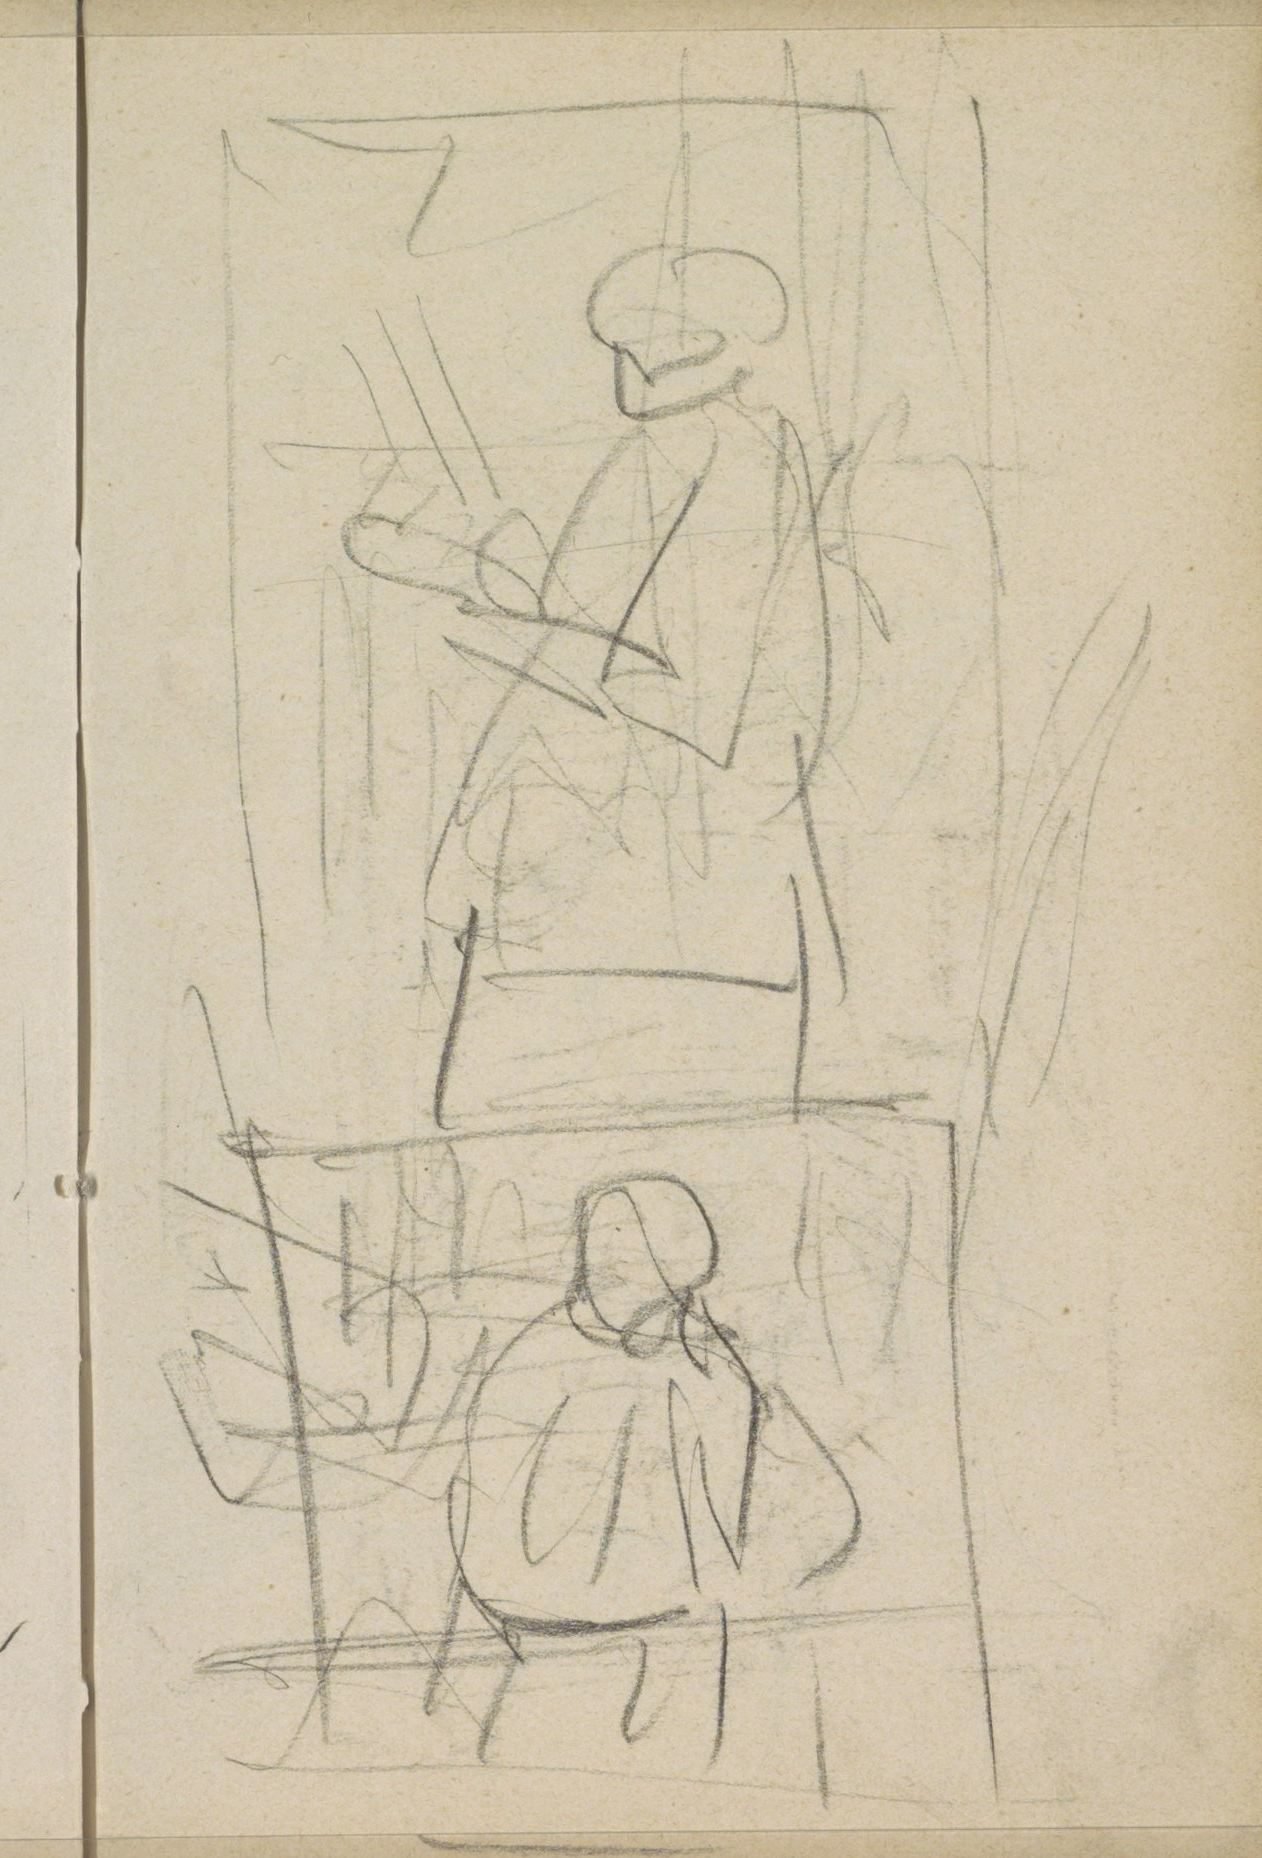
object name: sketchbook leaf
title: Compositiestudies van vrouwen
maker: george hendrik breitner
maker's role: draughtsman, painter, print maker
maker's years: 1857-1923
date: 1886-1908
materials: chalk, paper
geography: amsterdam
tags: adult woman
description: Pagina 70 uit een schetsboek met 46 bladen vervaardigd te Amsterdam, Haarlem en Antwerpen.